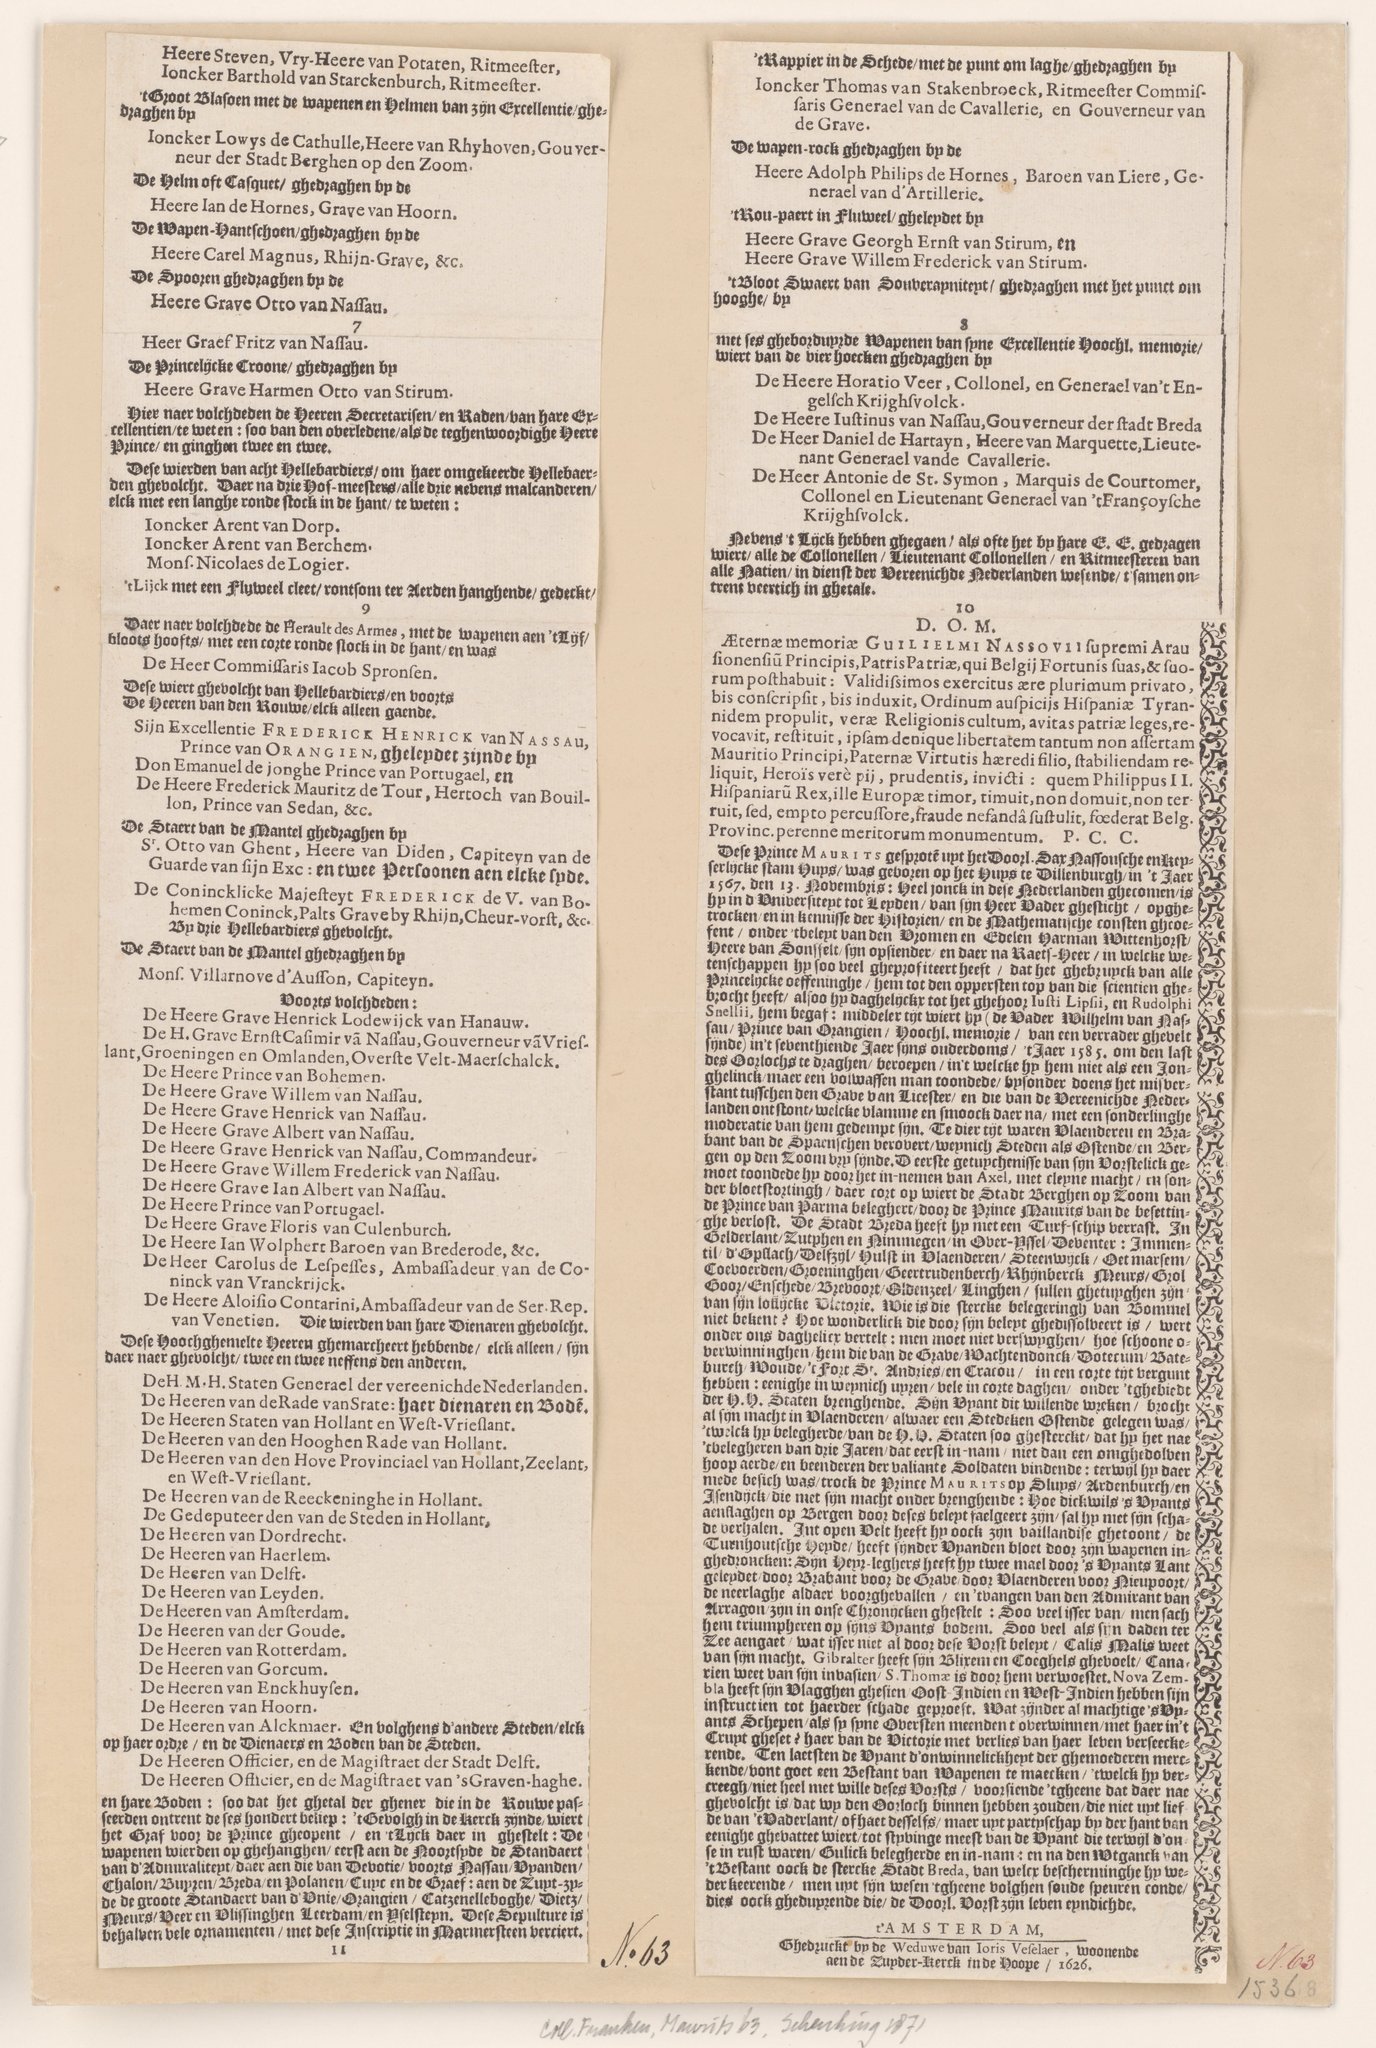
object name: text sheet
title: Beschryvinghe van de Uytvaert des Hoochgeboren Vorsts Maurits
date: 1626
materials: paper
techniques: letterpress printing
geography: amsterdam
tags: the hague, maurice (prince of orange), delft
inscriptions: collector's mark: Lugt 963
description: De begrafenisstoet van prins Maurits te Delft op 16 september 1625. Grote voorstelling van de ceremonie, bestaande uit 4 te monteren bladen, een titel en bijbehorende tekstblaadjes (genummerd 1-12). Op dit blad in twee kolommen de opgeplakte tekstblaadjes genummerd 7-[12], te monteren aan de onder- en rechterzijde van de prent.